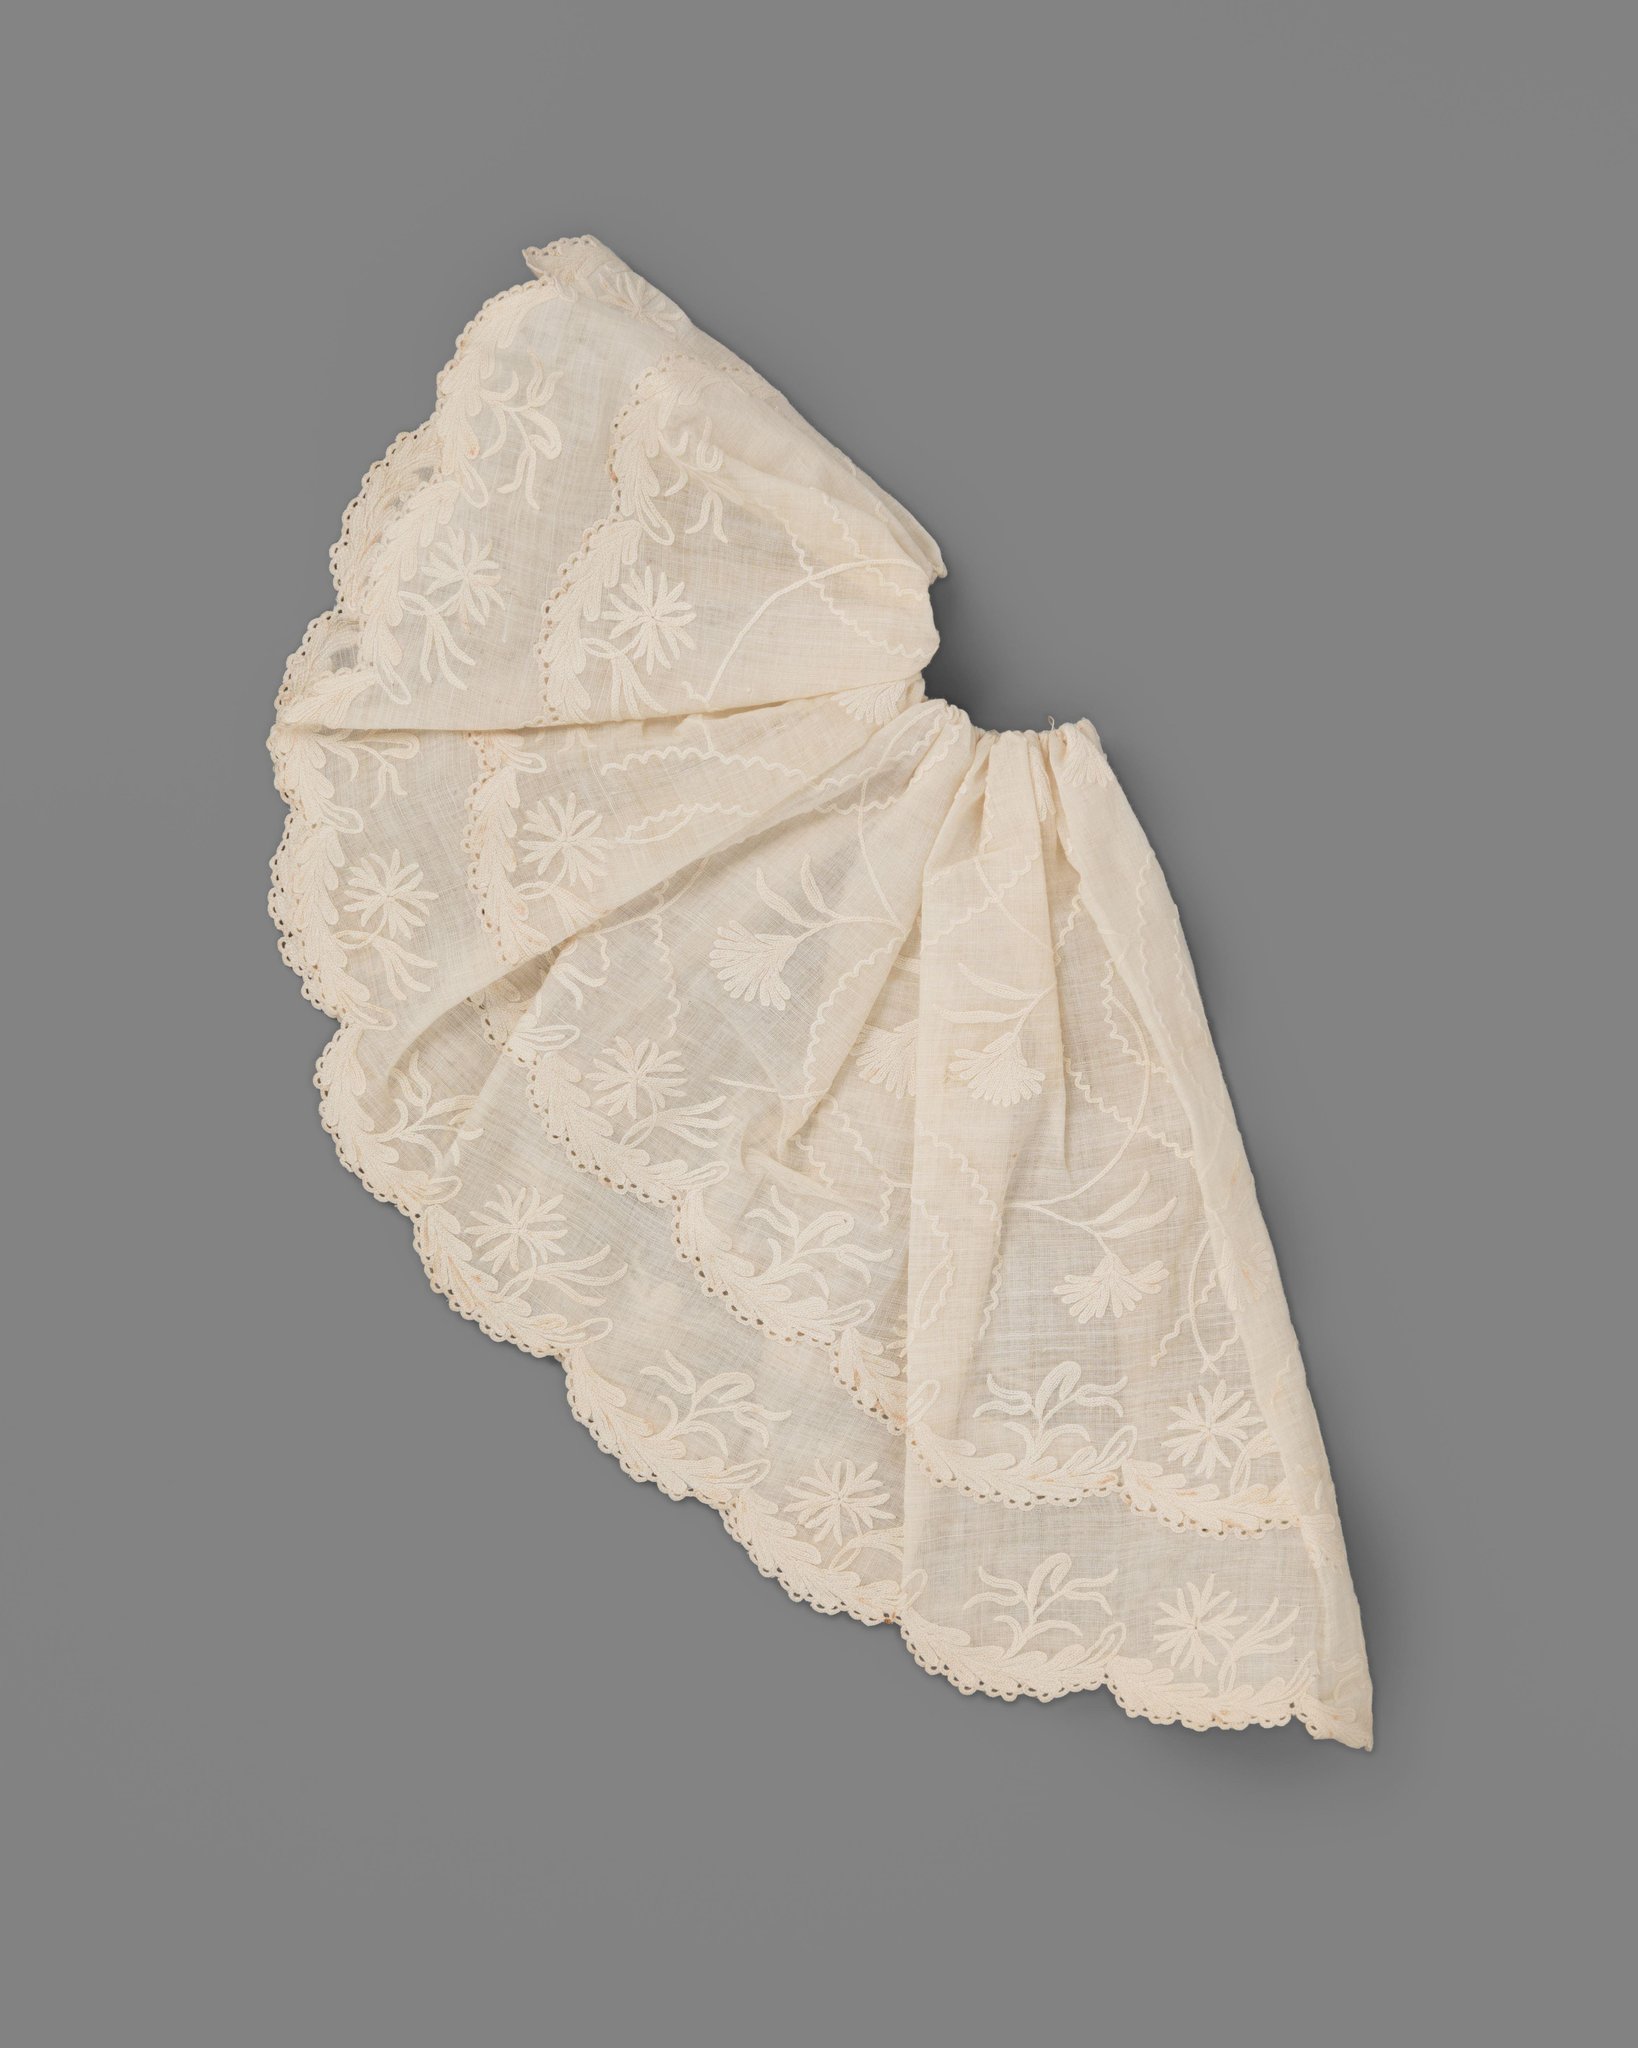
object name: womenswear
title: Engageante met floraal tamboereerwerk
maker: Anonymous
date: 1750-1775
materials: linen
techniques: embroidered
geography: western europe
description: Engageante met floraal tamboereerwerk. De engageante lijkt uit twee lagen te bestaan door een tweemaal geschulpte omtrek.